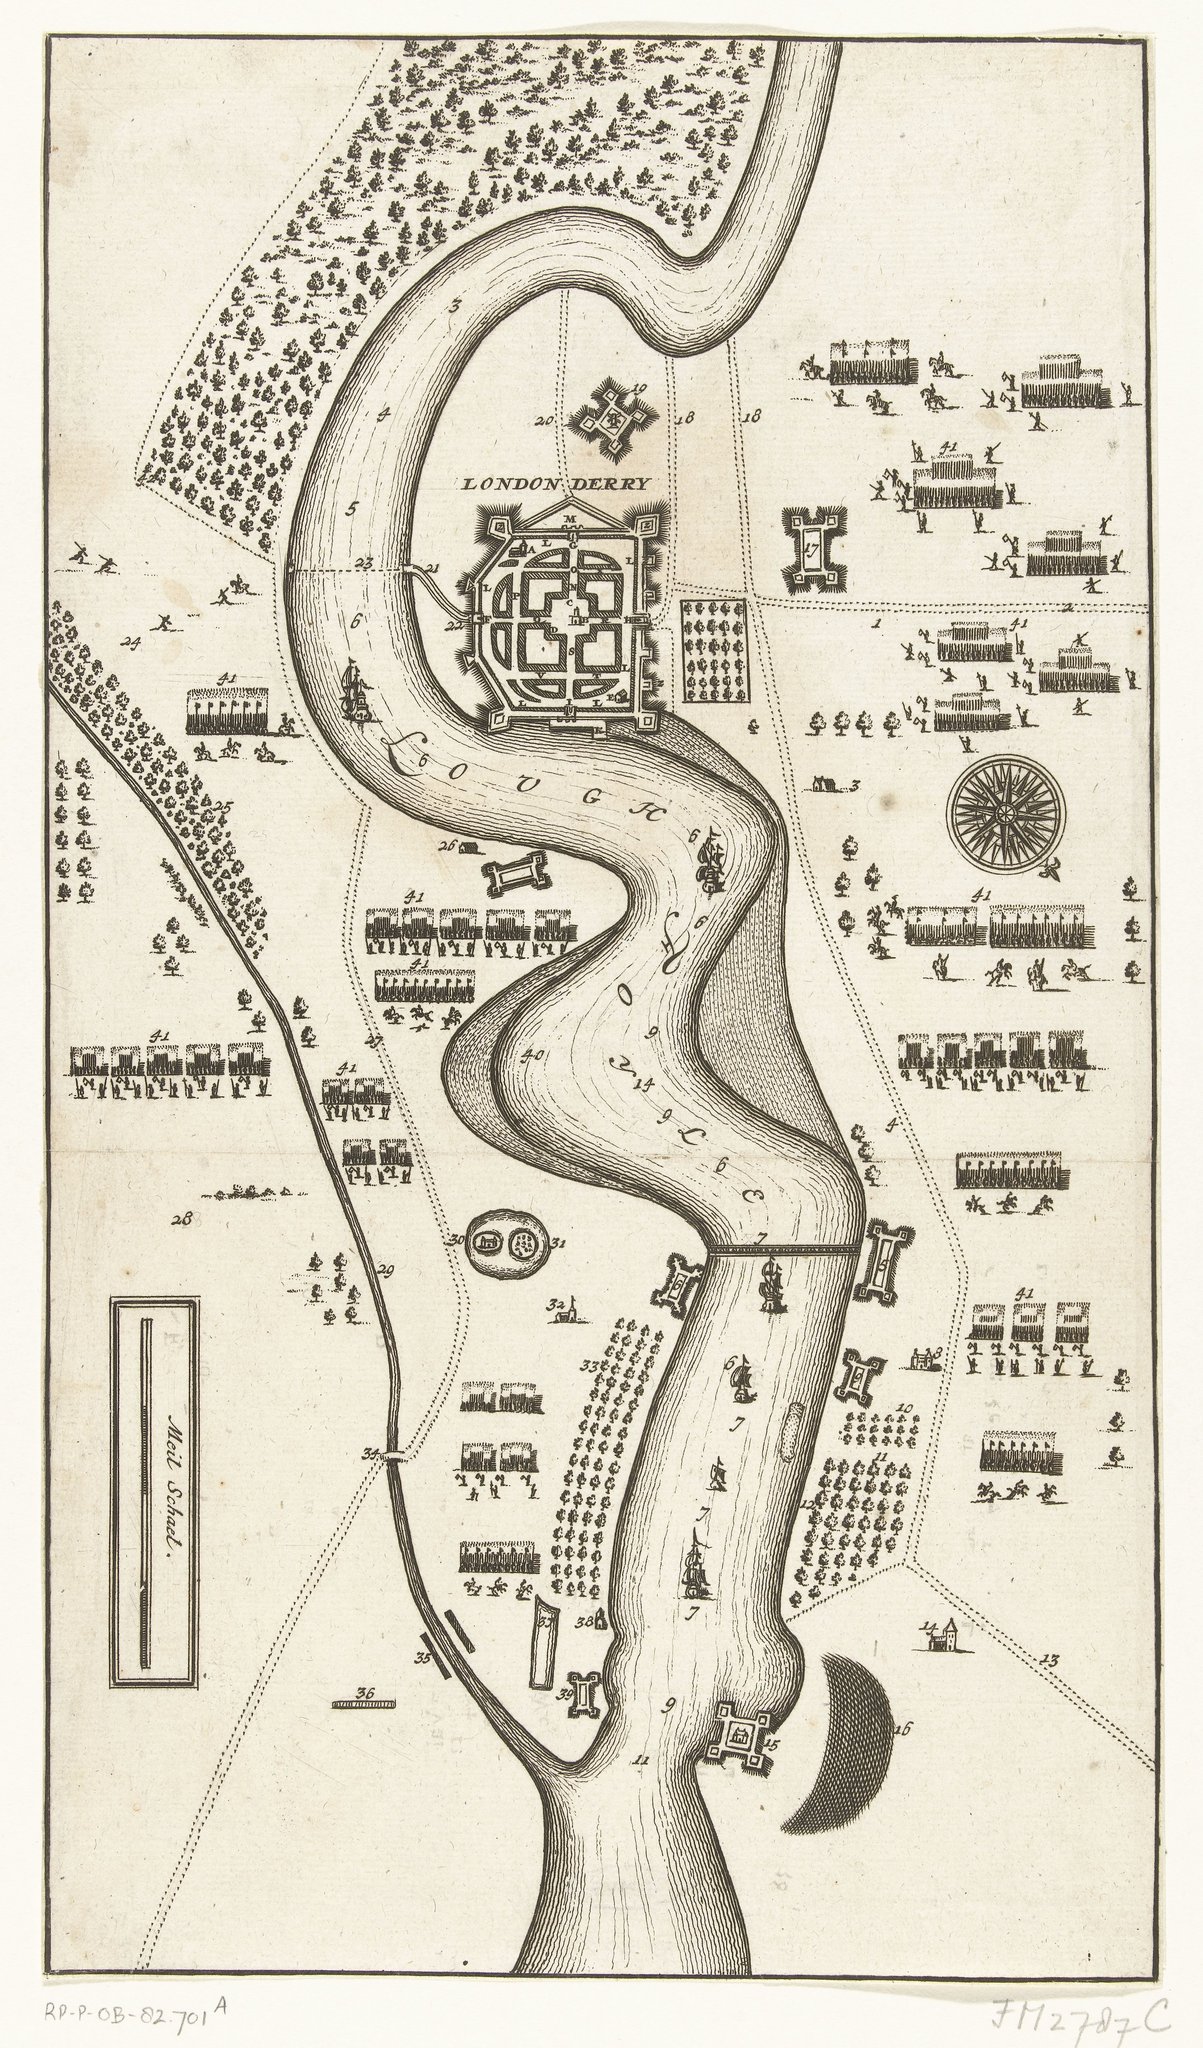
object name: print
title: Kaart van het beleg van Londonderry, 1689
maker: Anonymous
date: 1689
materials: paper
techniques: engraving, etching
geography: northern netherlands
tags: jacobus ii (koning van engeland en schotland), siege, position war, maps of cities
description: Kaart van het beleg van Londonderry door het leger van Jacobus II, 18 april t/m 28 juli 1689. Bij de kaart behoort een afzonderlijk tekstblad met de legenda.